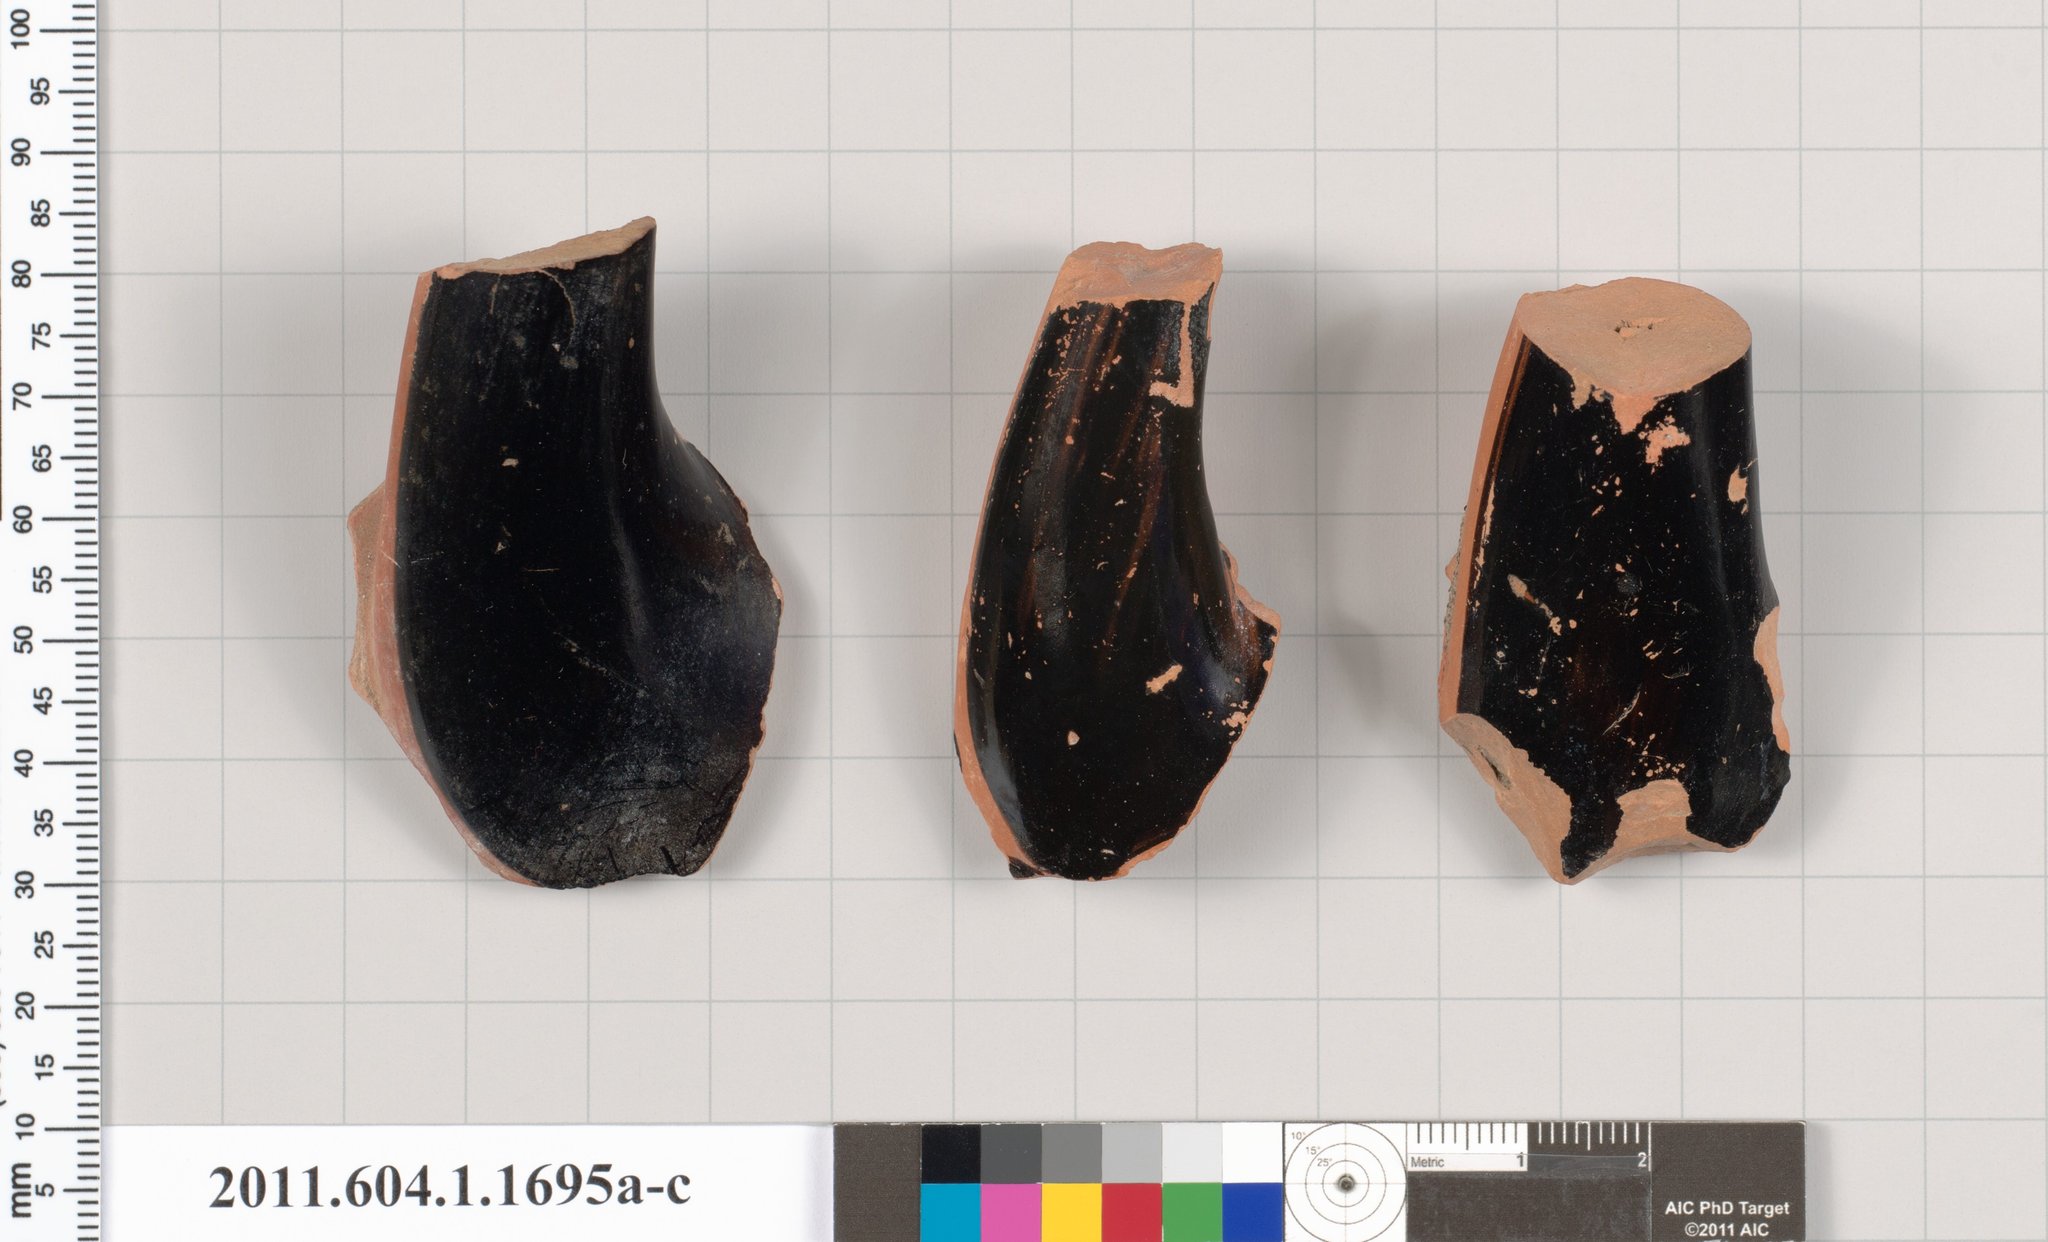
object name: kylix fragment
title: Terracotta fragments of kylikes (drinking cups)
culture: greek, attic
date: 500-401 BCE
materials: terracotta